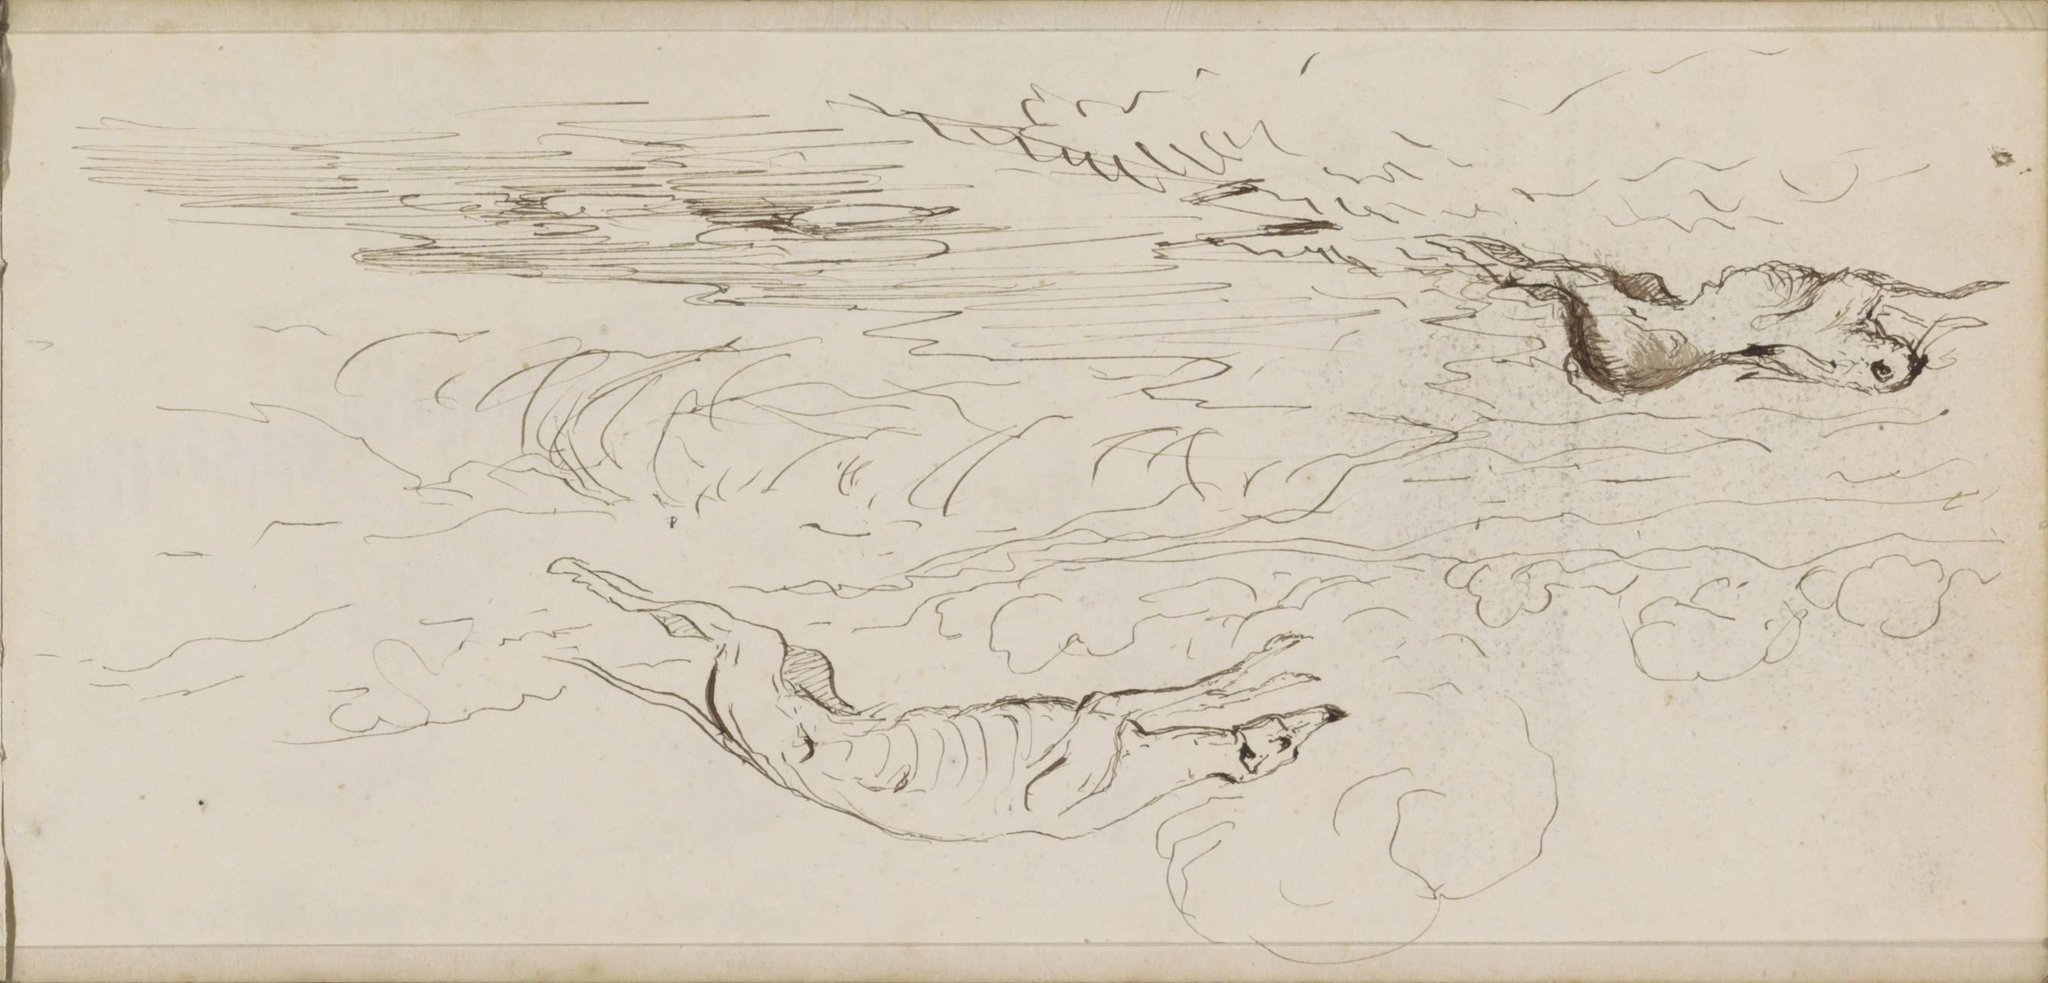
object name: sketchbook leaf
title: Landschap met wolkenlucht, een hond en een haas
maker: johannes tavenraat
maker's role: draughtsman, painter, print maker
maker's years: 1809-1881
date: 1840-1868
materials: ink, paper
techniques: pen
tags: landscapes, clouds, rodents: hare, dog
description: Blad 62 recto uit een schetsboek met 63 bladen.